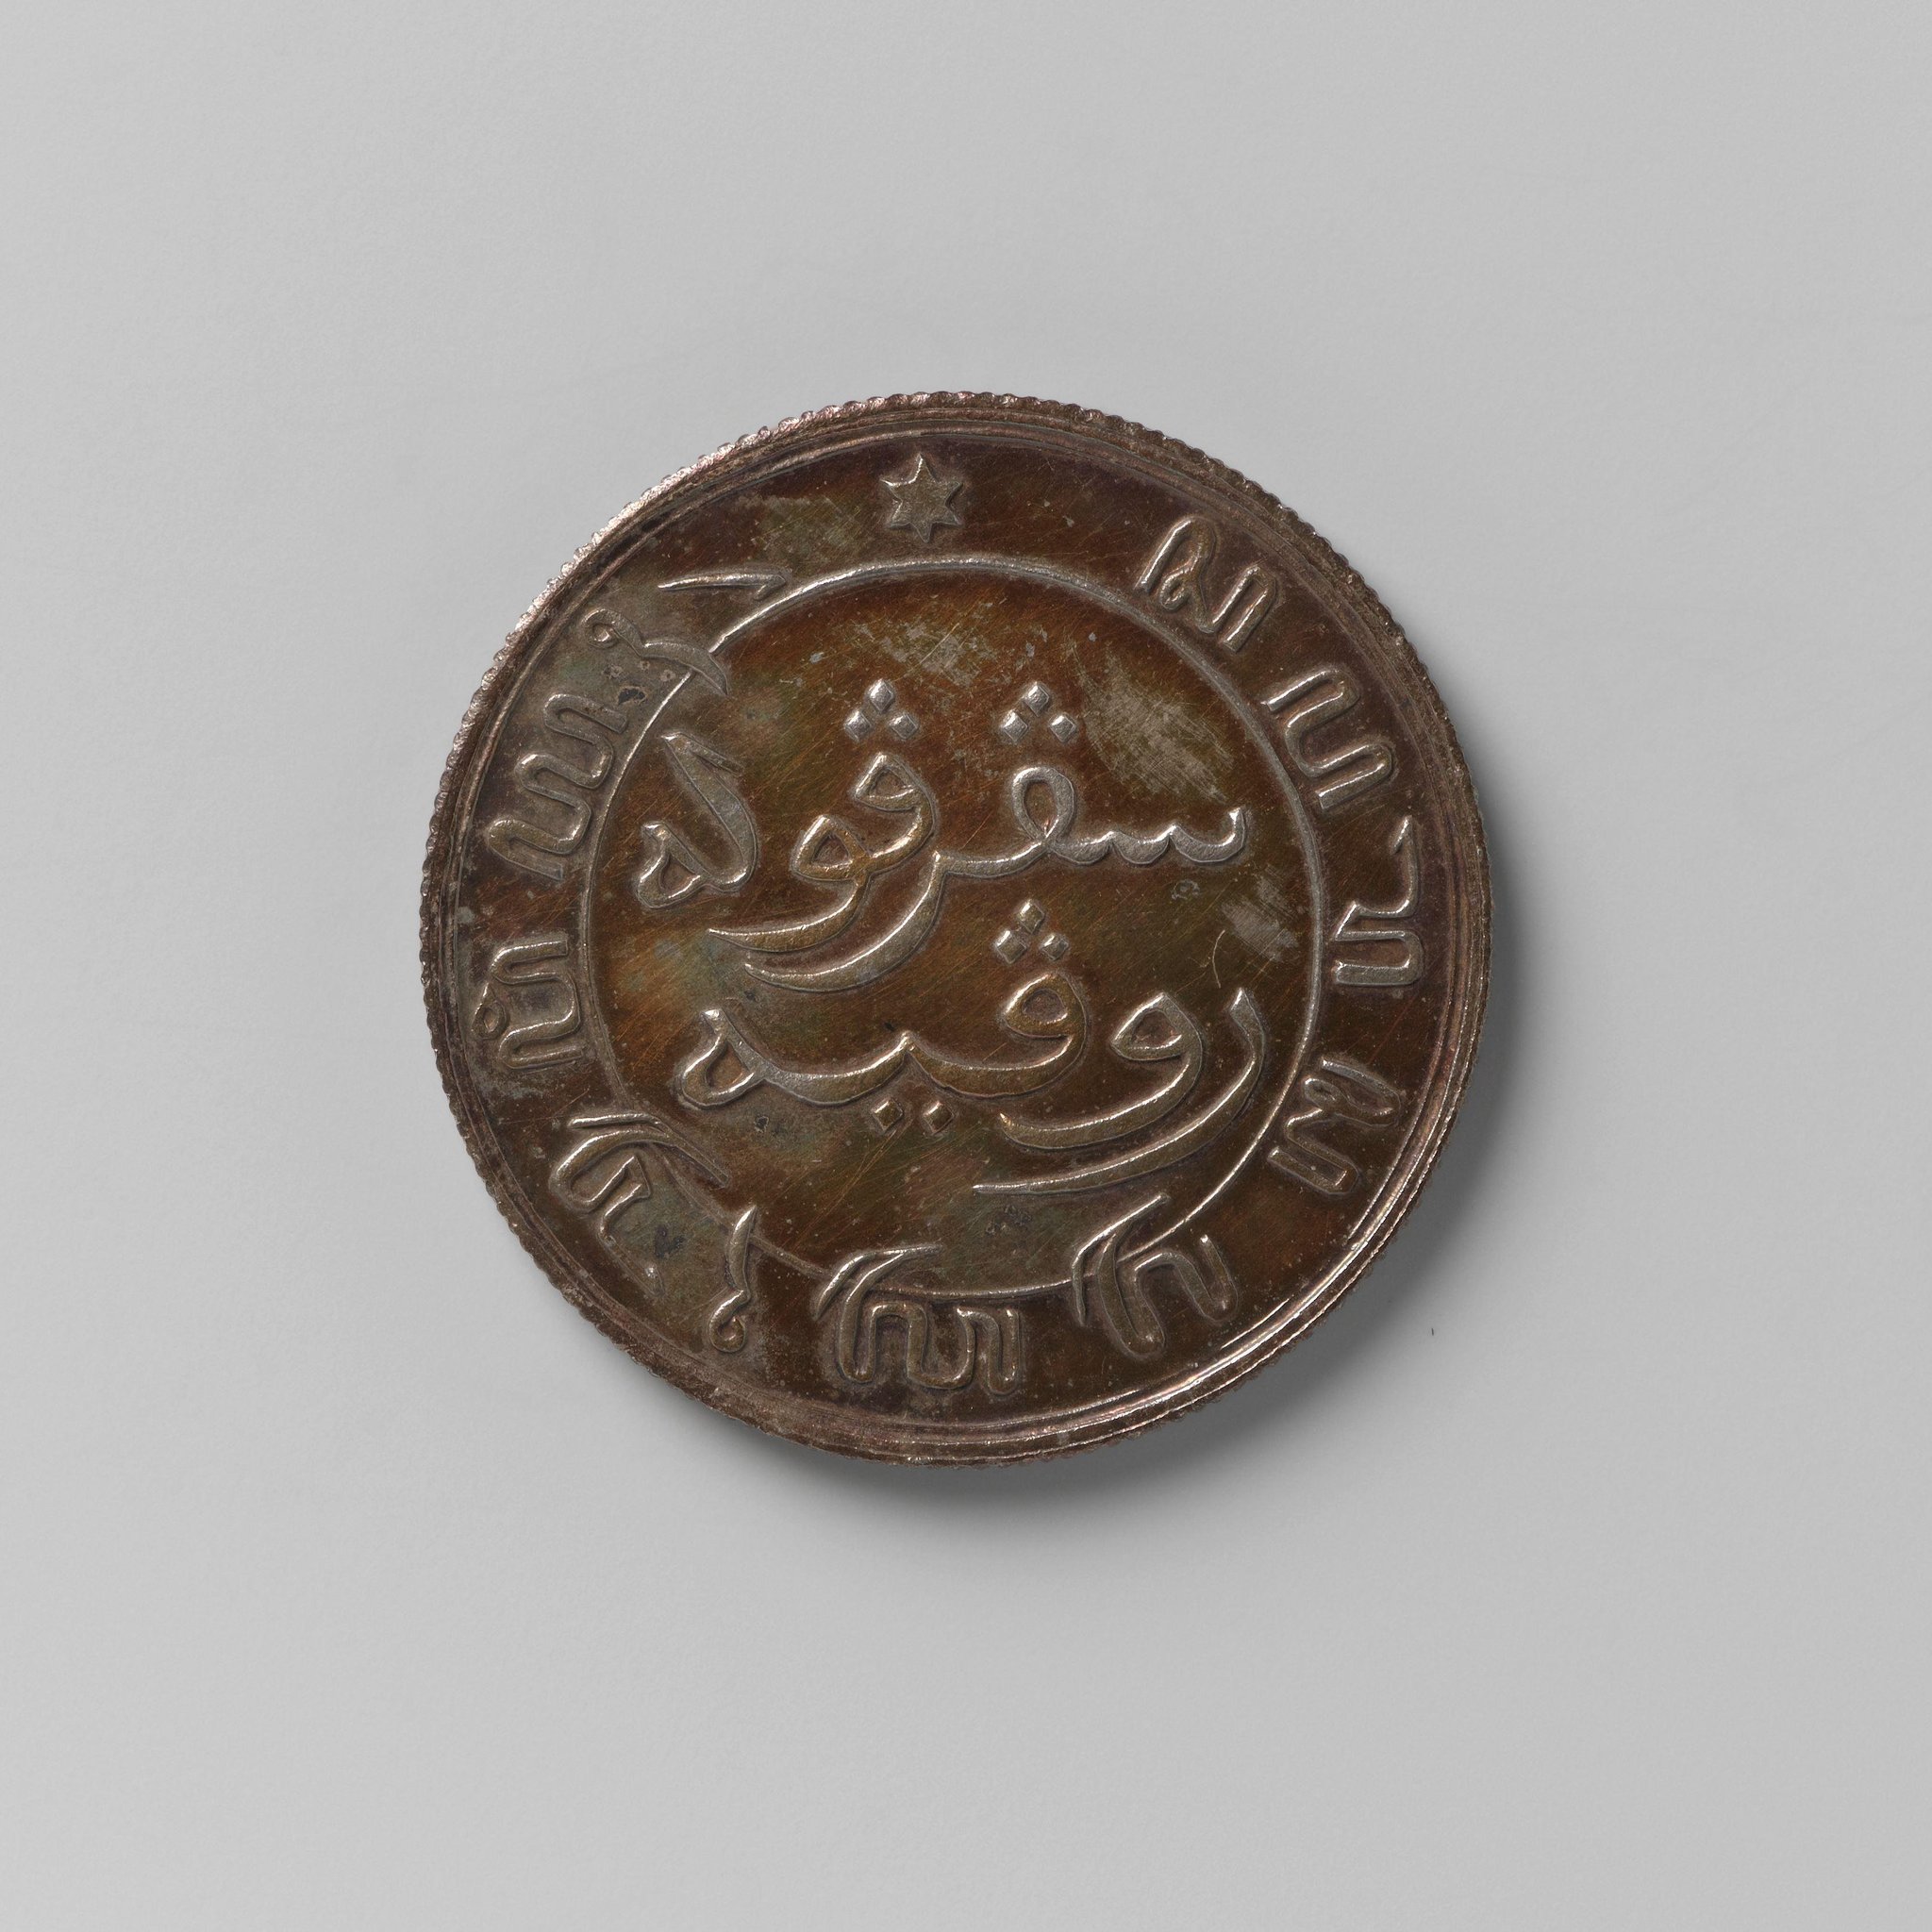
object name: tiende gulden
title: Nederlands Indië, 1/10 gulden, 1884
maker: willem iii (koning der nederlanden)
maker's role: koning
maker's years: 1817-1890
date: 1884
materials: copper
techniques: striking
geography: utrecht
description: Zilveren munt. Voorzijde: tussen waarde-aanduiding 1/10 G gekroond rijkswapenschild. Boven kroon landsaanduiding en onder wapenschild jaartal. Keerzijde: tweeregelig Maleis opschrift in Arabische tekens, waaromheen omschrift in het Javaans. Kartelrand.